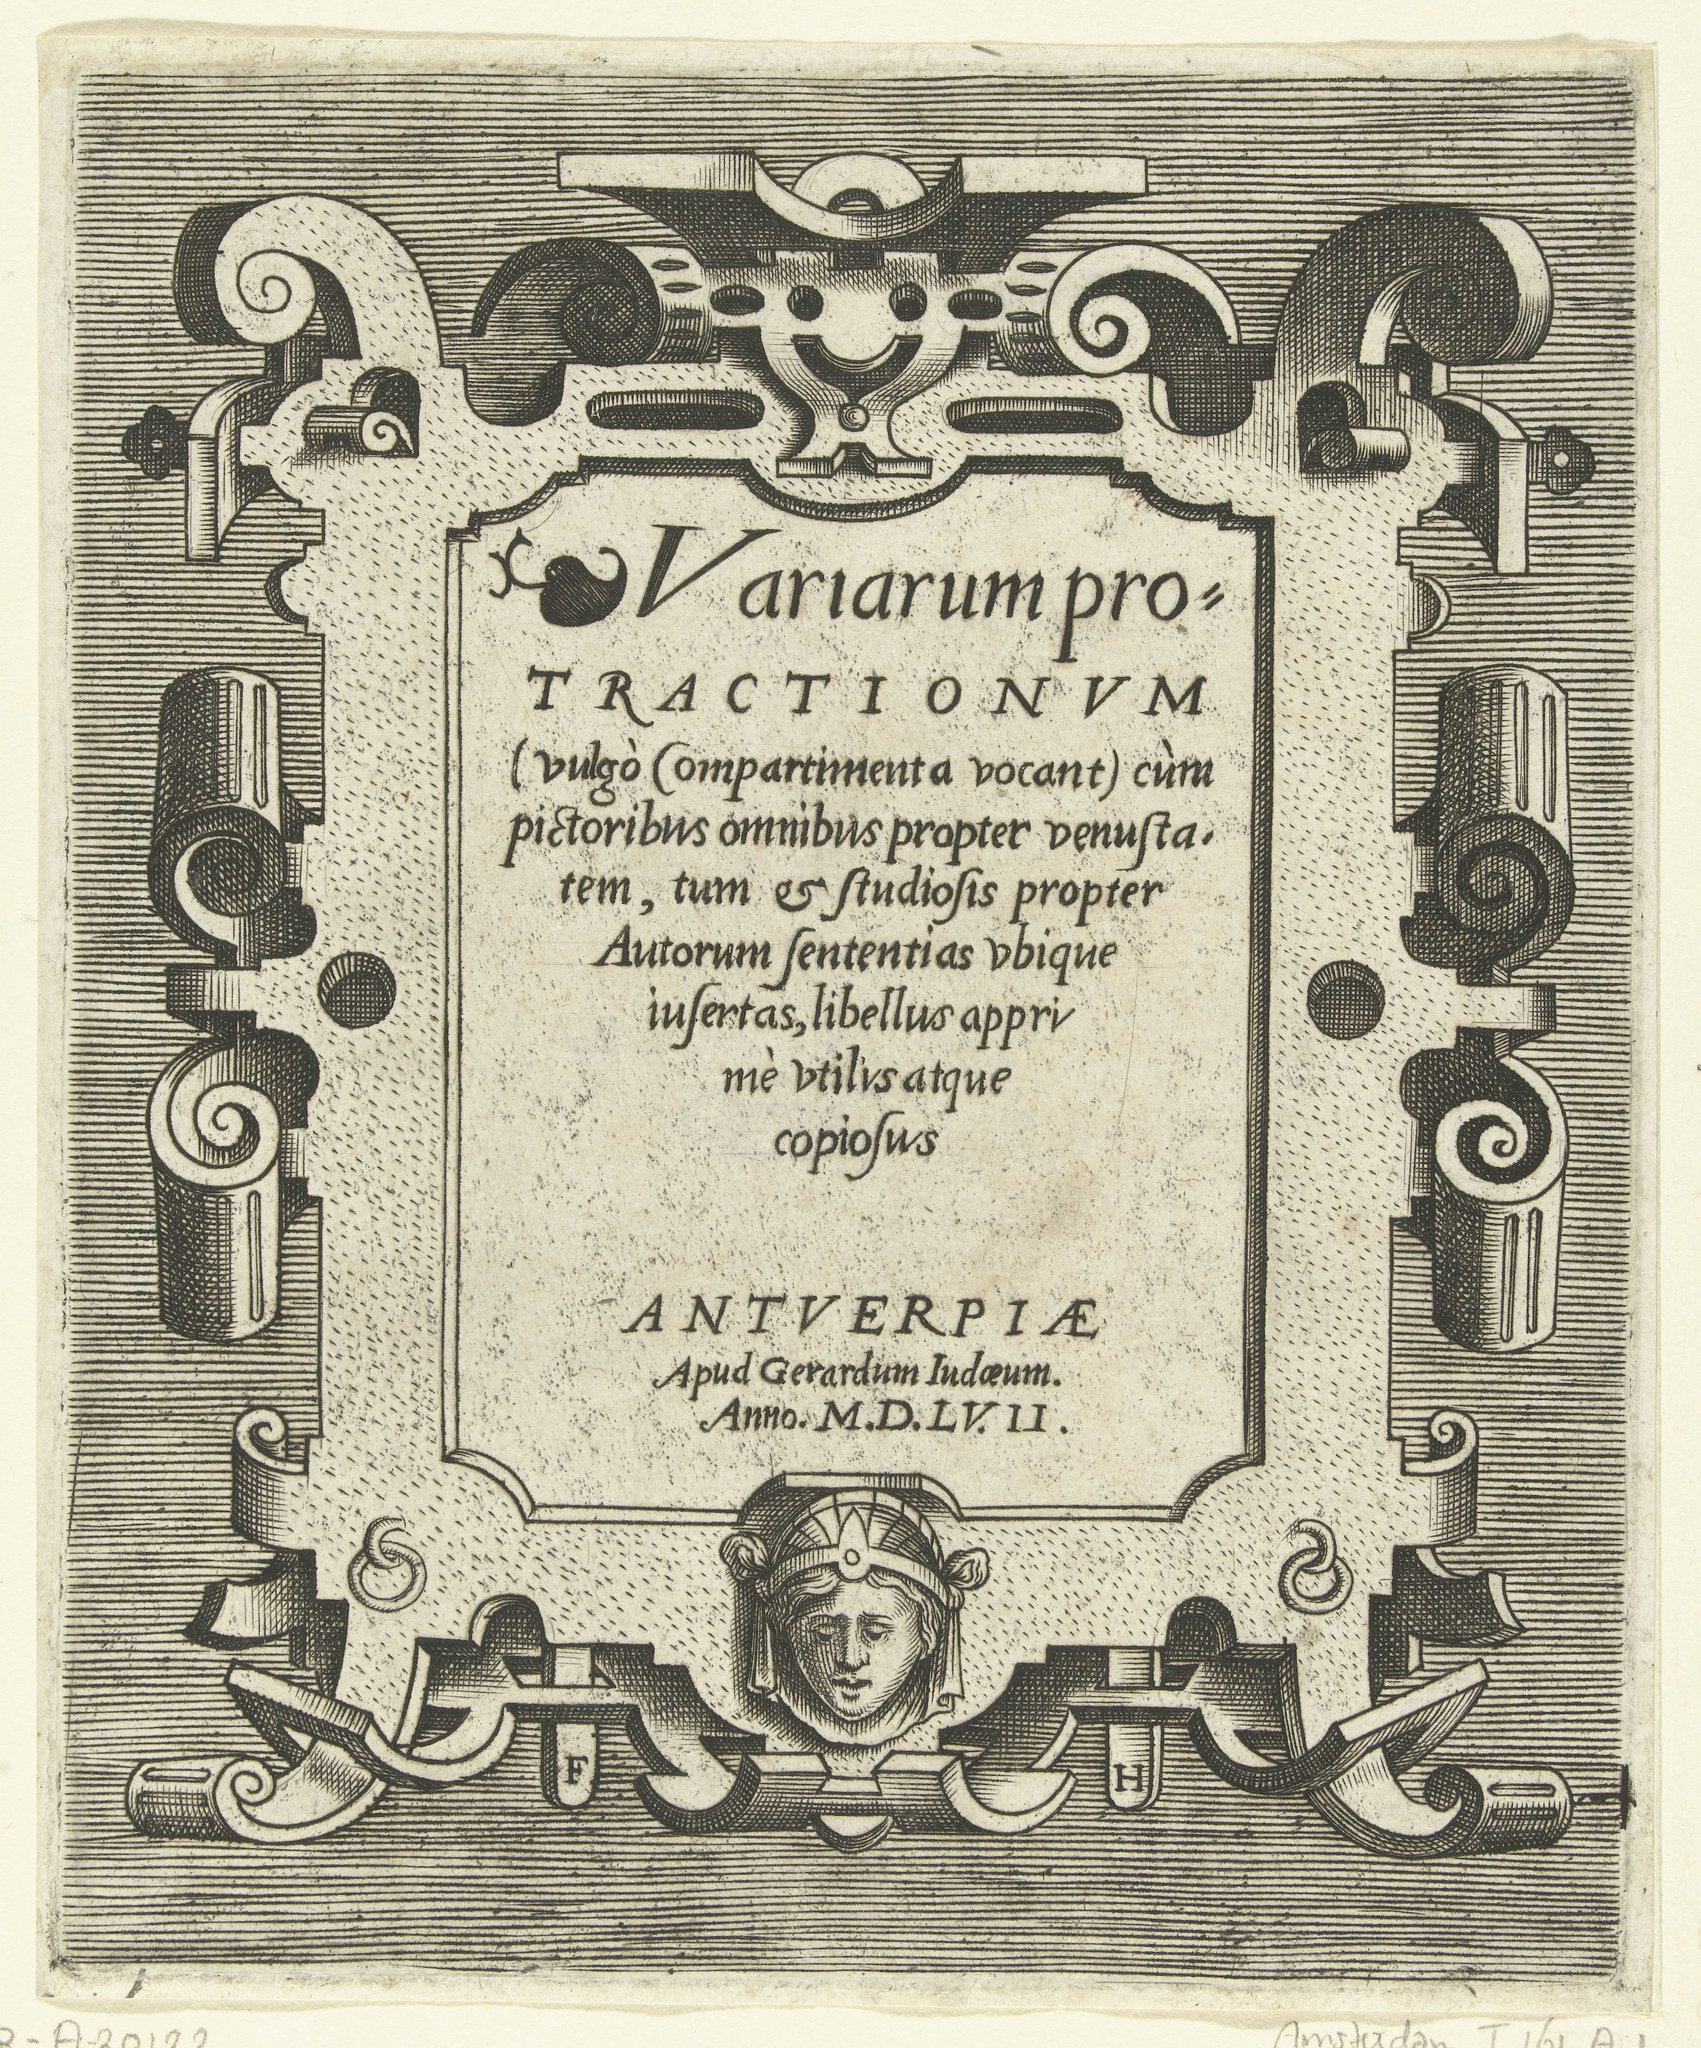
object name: ornament print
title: Variarum protractionum (...)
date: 1557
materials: paper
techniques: etching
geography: netherlands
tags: title-page, ornament ~ cartouche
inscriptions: date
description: Cartouche met daarin de titel. Tweede editie (1557) van serie cartouches met citaten van klassieke schrijvers in een omlijsting van rolwerk met grotesken, mascarons en guirlandes. Gearceerde achtergrond.